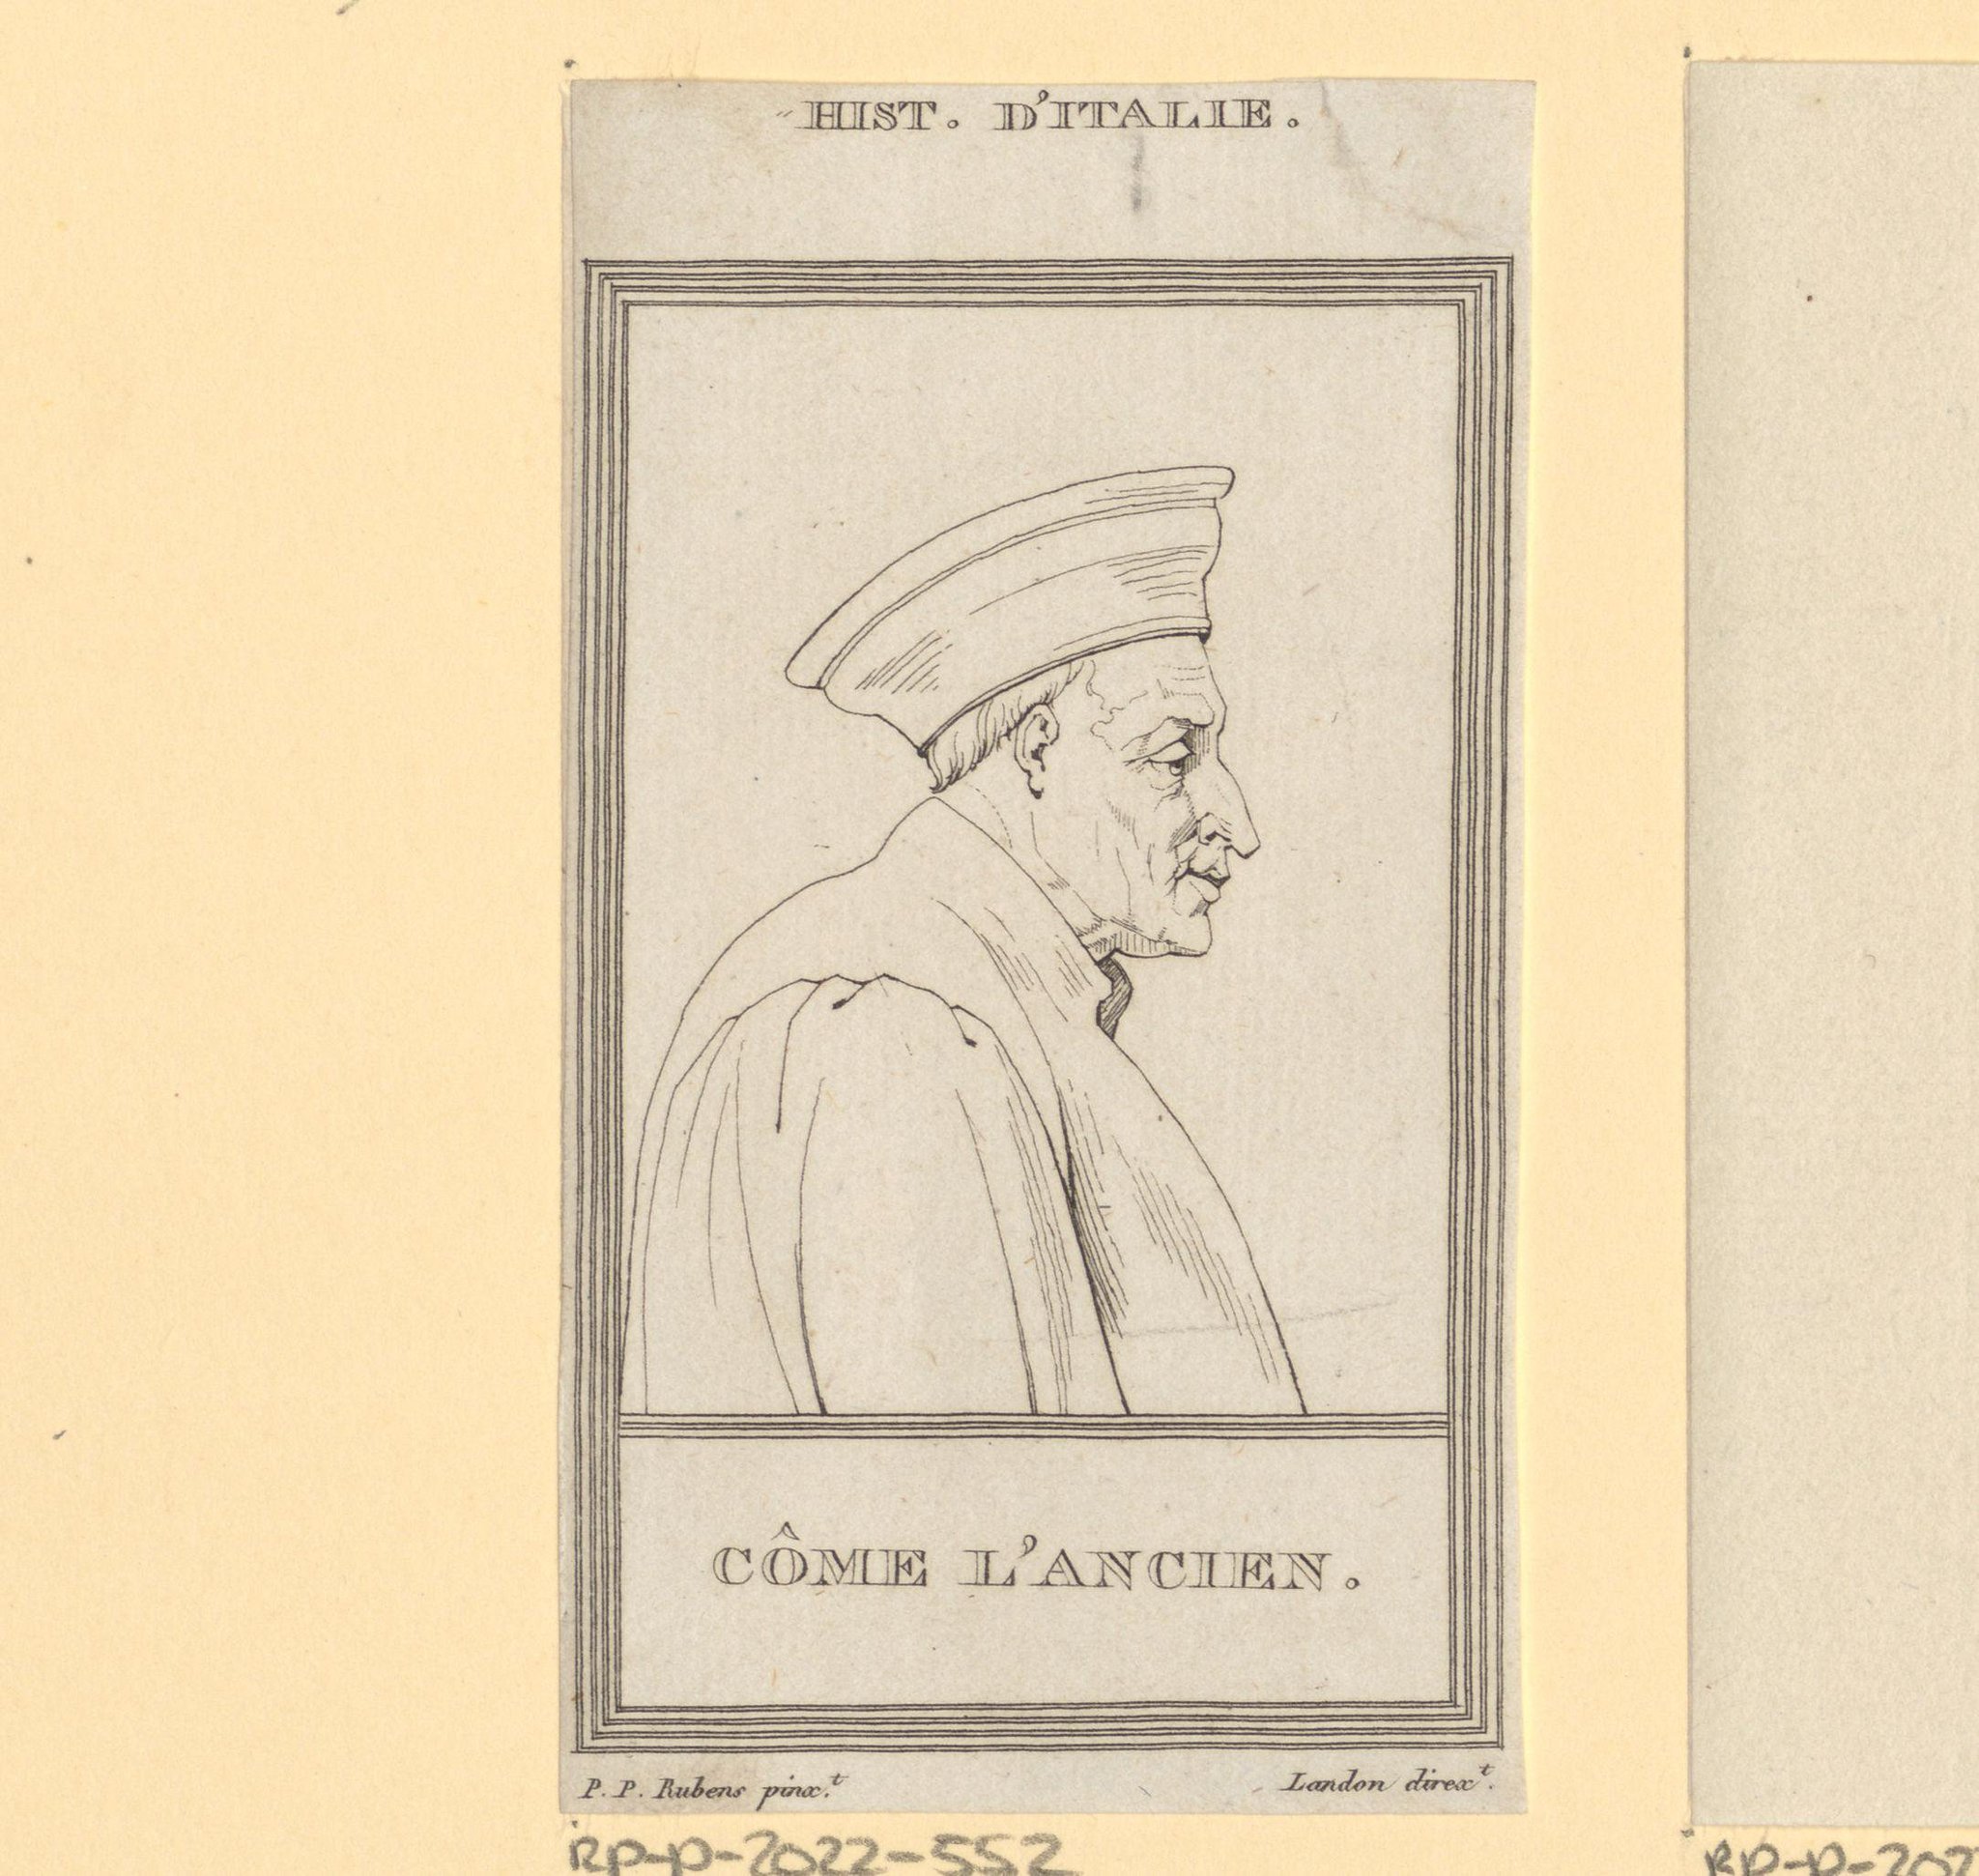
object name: print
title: Portret van Cosimo de' Medici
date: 1805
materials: paper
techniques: etching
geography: paris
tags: politician, historical persons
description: Prent waarschijnlijk uit: Galerie historique des hommes les plus célèbres (...). Parijs: Charles Paul Landon, 1805, dl. 4.